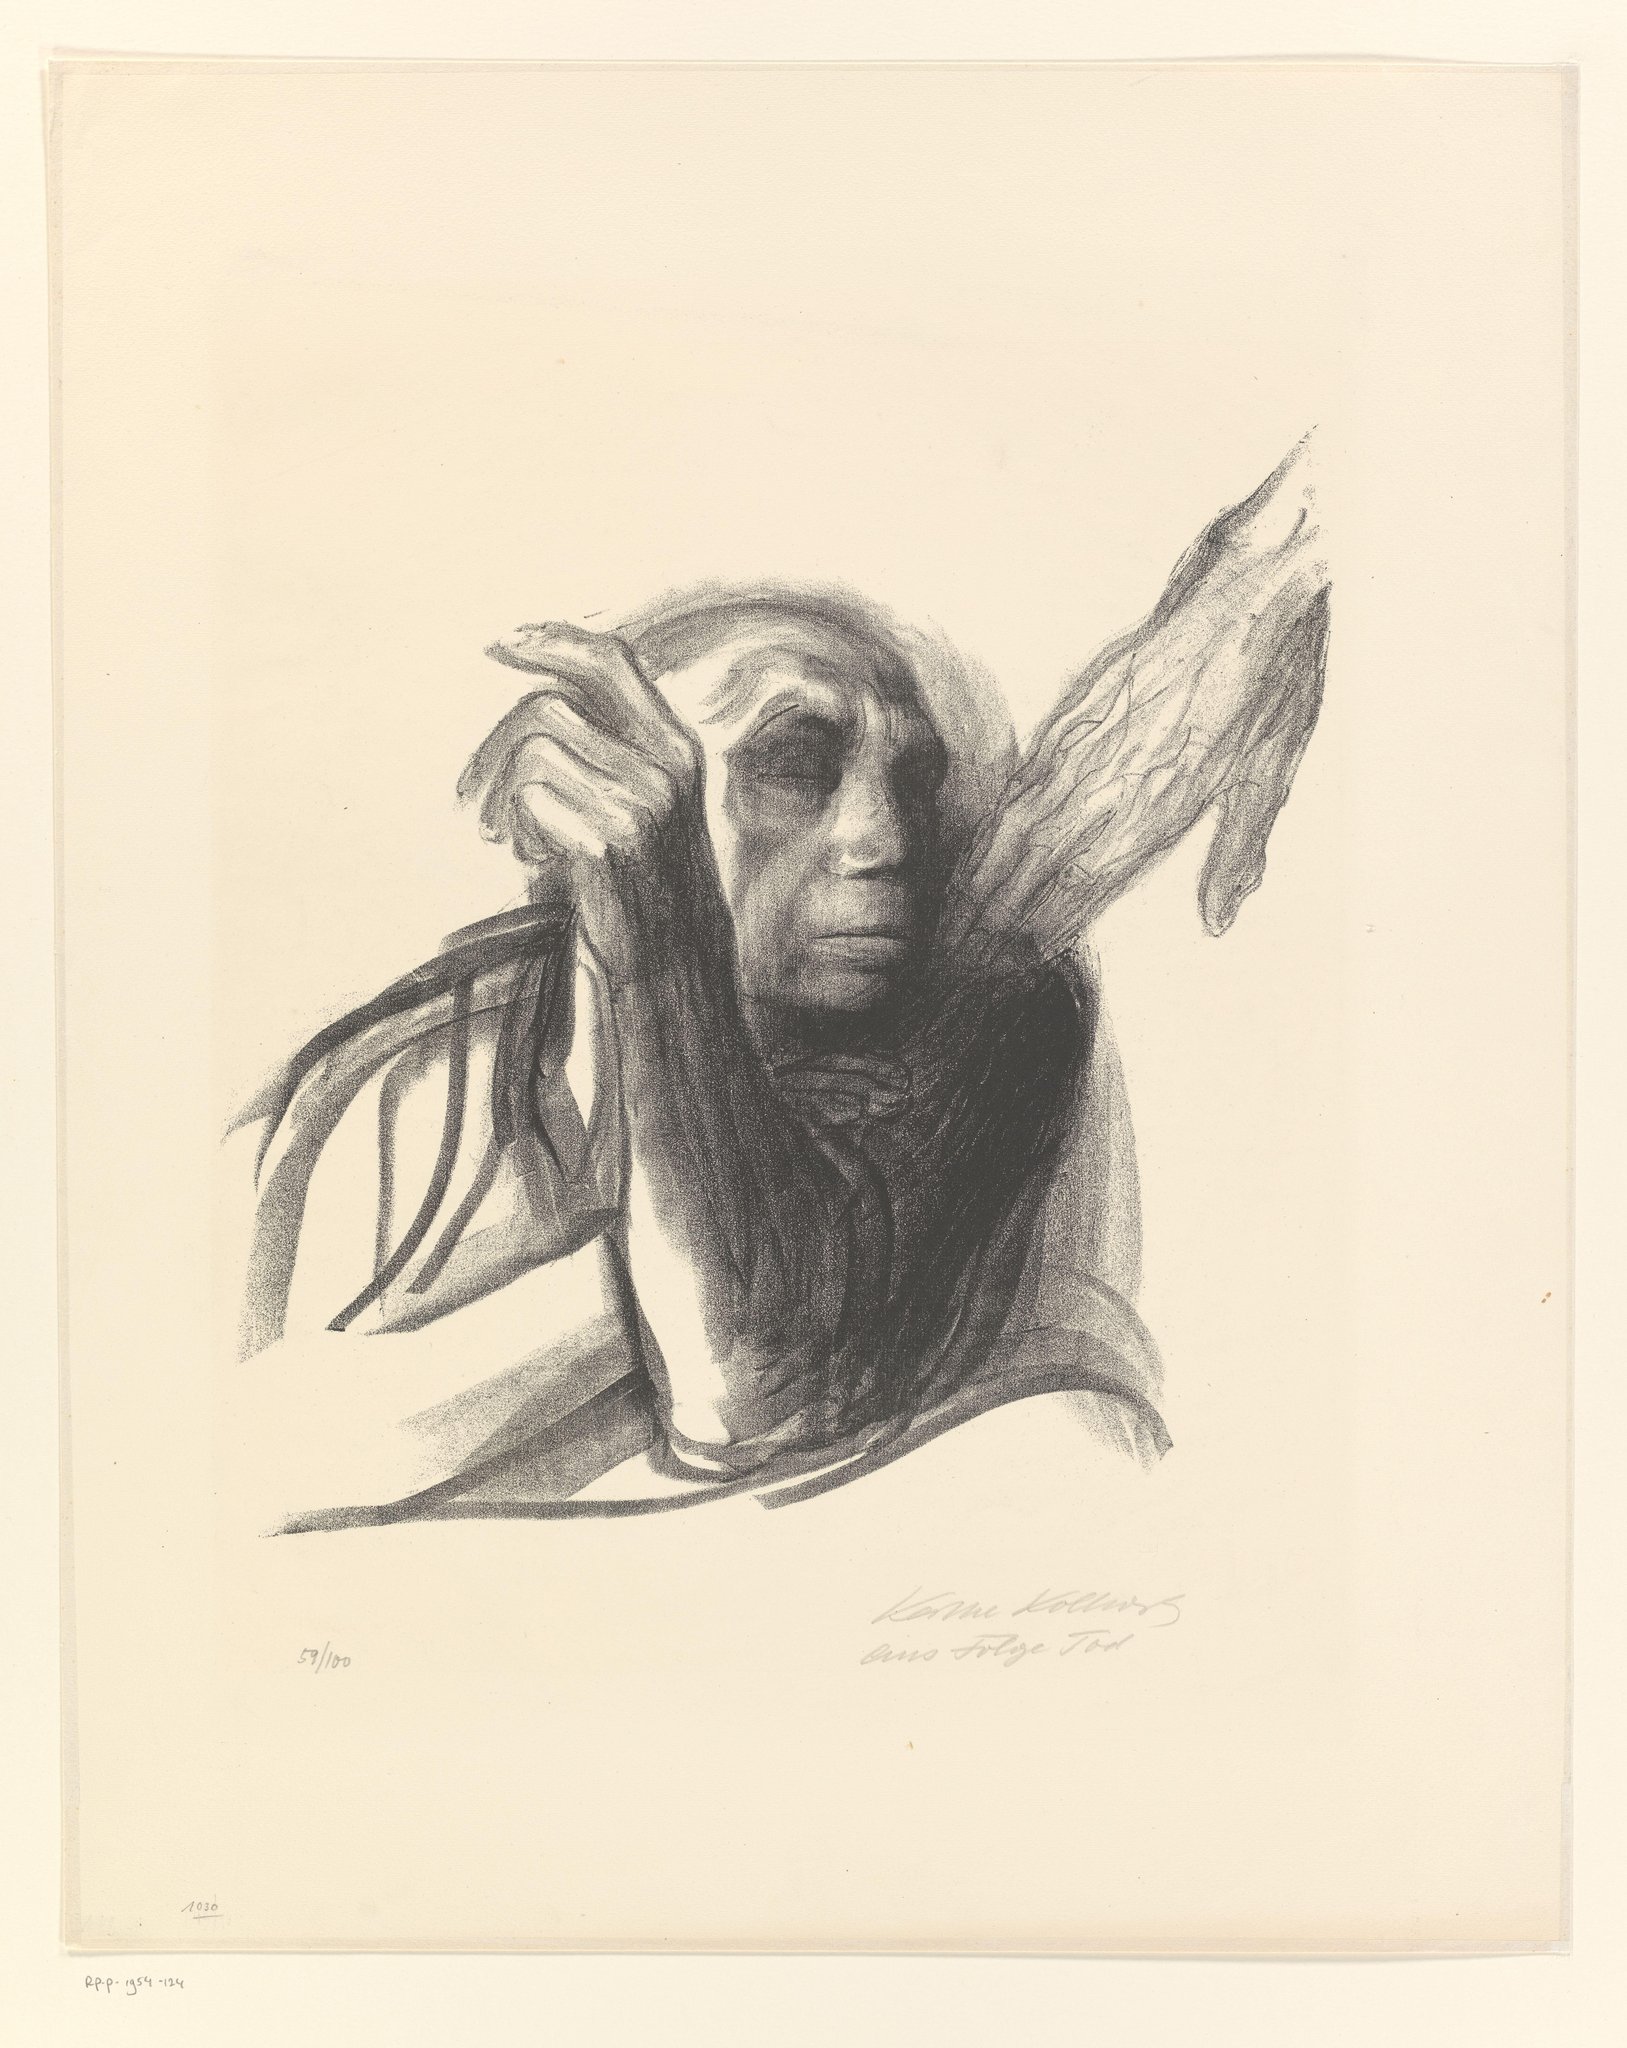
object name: print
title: Dood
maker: käthe kollwitz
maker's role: draughtsman, print maker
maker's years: 1867-1945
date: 1934-1937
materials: paper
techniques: lithograph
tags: draughtsman, käthe kollwitz, hand, historical persons, old woman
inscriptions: collector's mark: Lugt 2228, collector's mark: Lugt 2760, inscription: ‘Aus Folge Tod.’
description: Deze prent behoort tot de serie 'Tod' van Käthe Kollwitz. De serie bestaat uit acht lithografieën over de dood, uitgevoerd tussen 1934 en 1937.